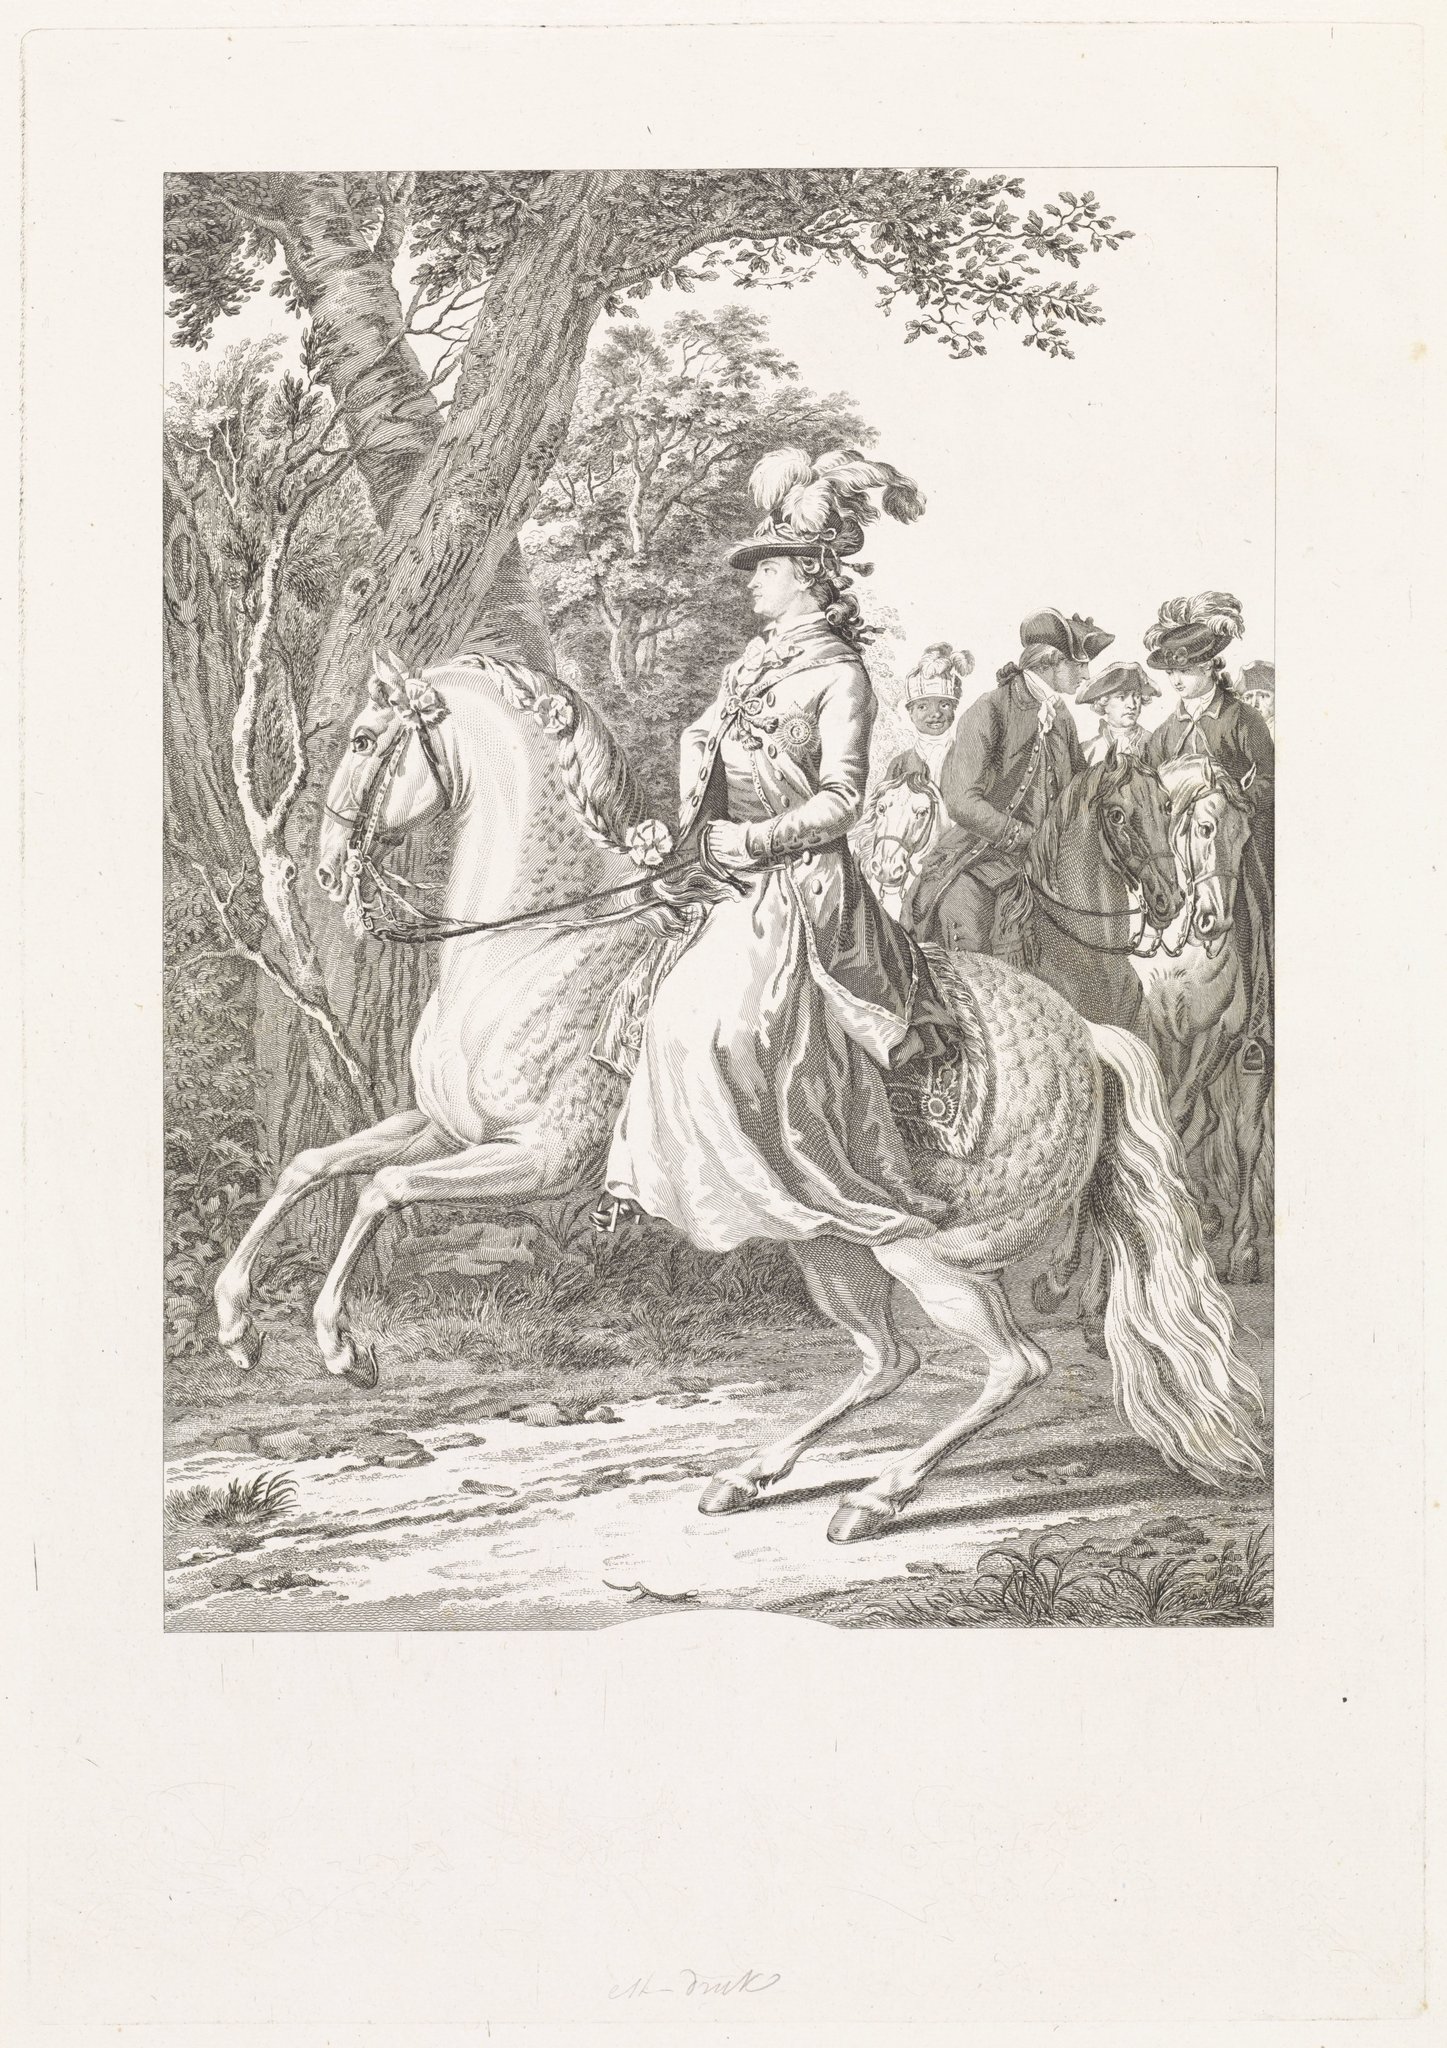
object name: print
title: Portret van Wilhelmina van Pruisen, te paard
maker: reinier vinkeles (i)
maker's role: draughtsman, print maker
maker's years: 1741-1816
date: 1779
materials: paper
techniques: etching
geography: amsterdam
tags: berlin, painter, wilhelmina of prussia (princess of orange), horse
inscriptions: collector's mark: Lugt 2228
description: Portret van Wilhelmina van Pruisen, te paard in een landschap. Achter haar haar gevolg.